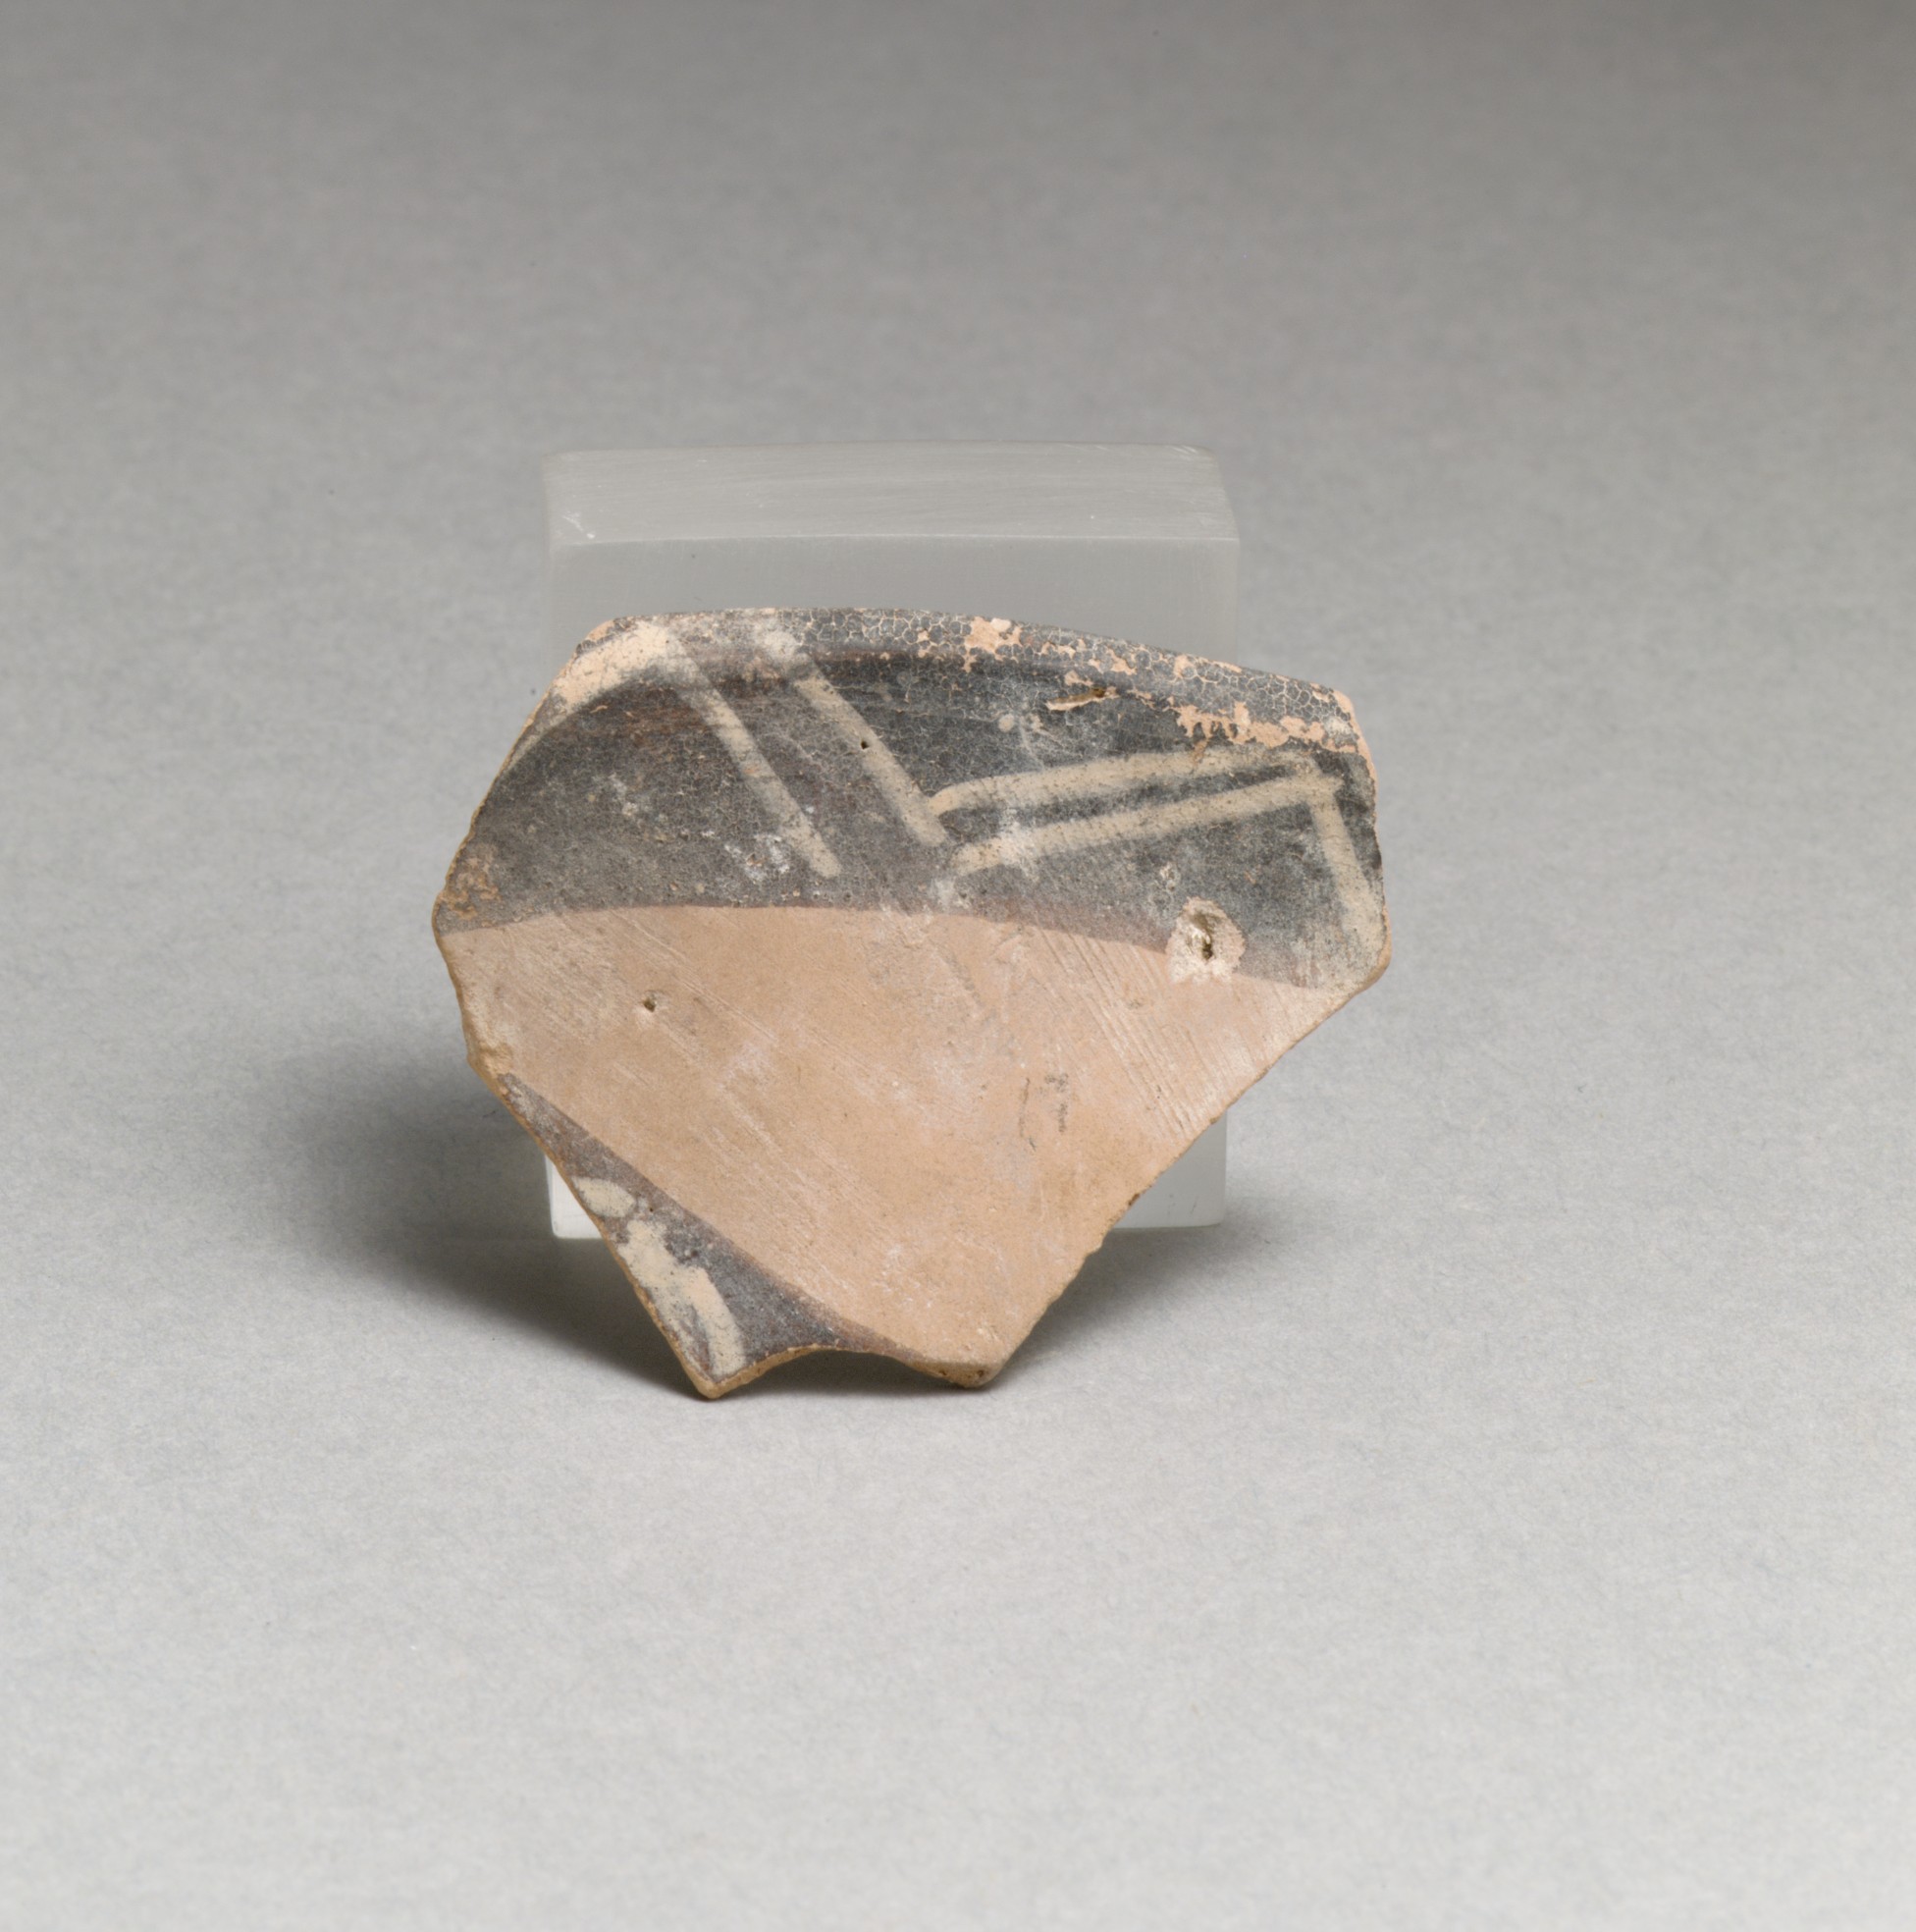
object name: vase fragment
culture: minoan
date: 2600-2000 BCE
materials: terracotta